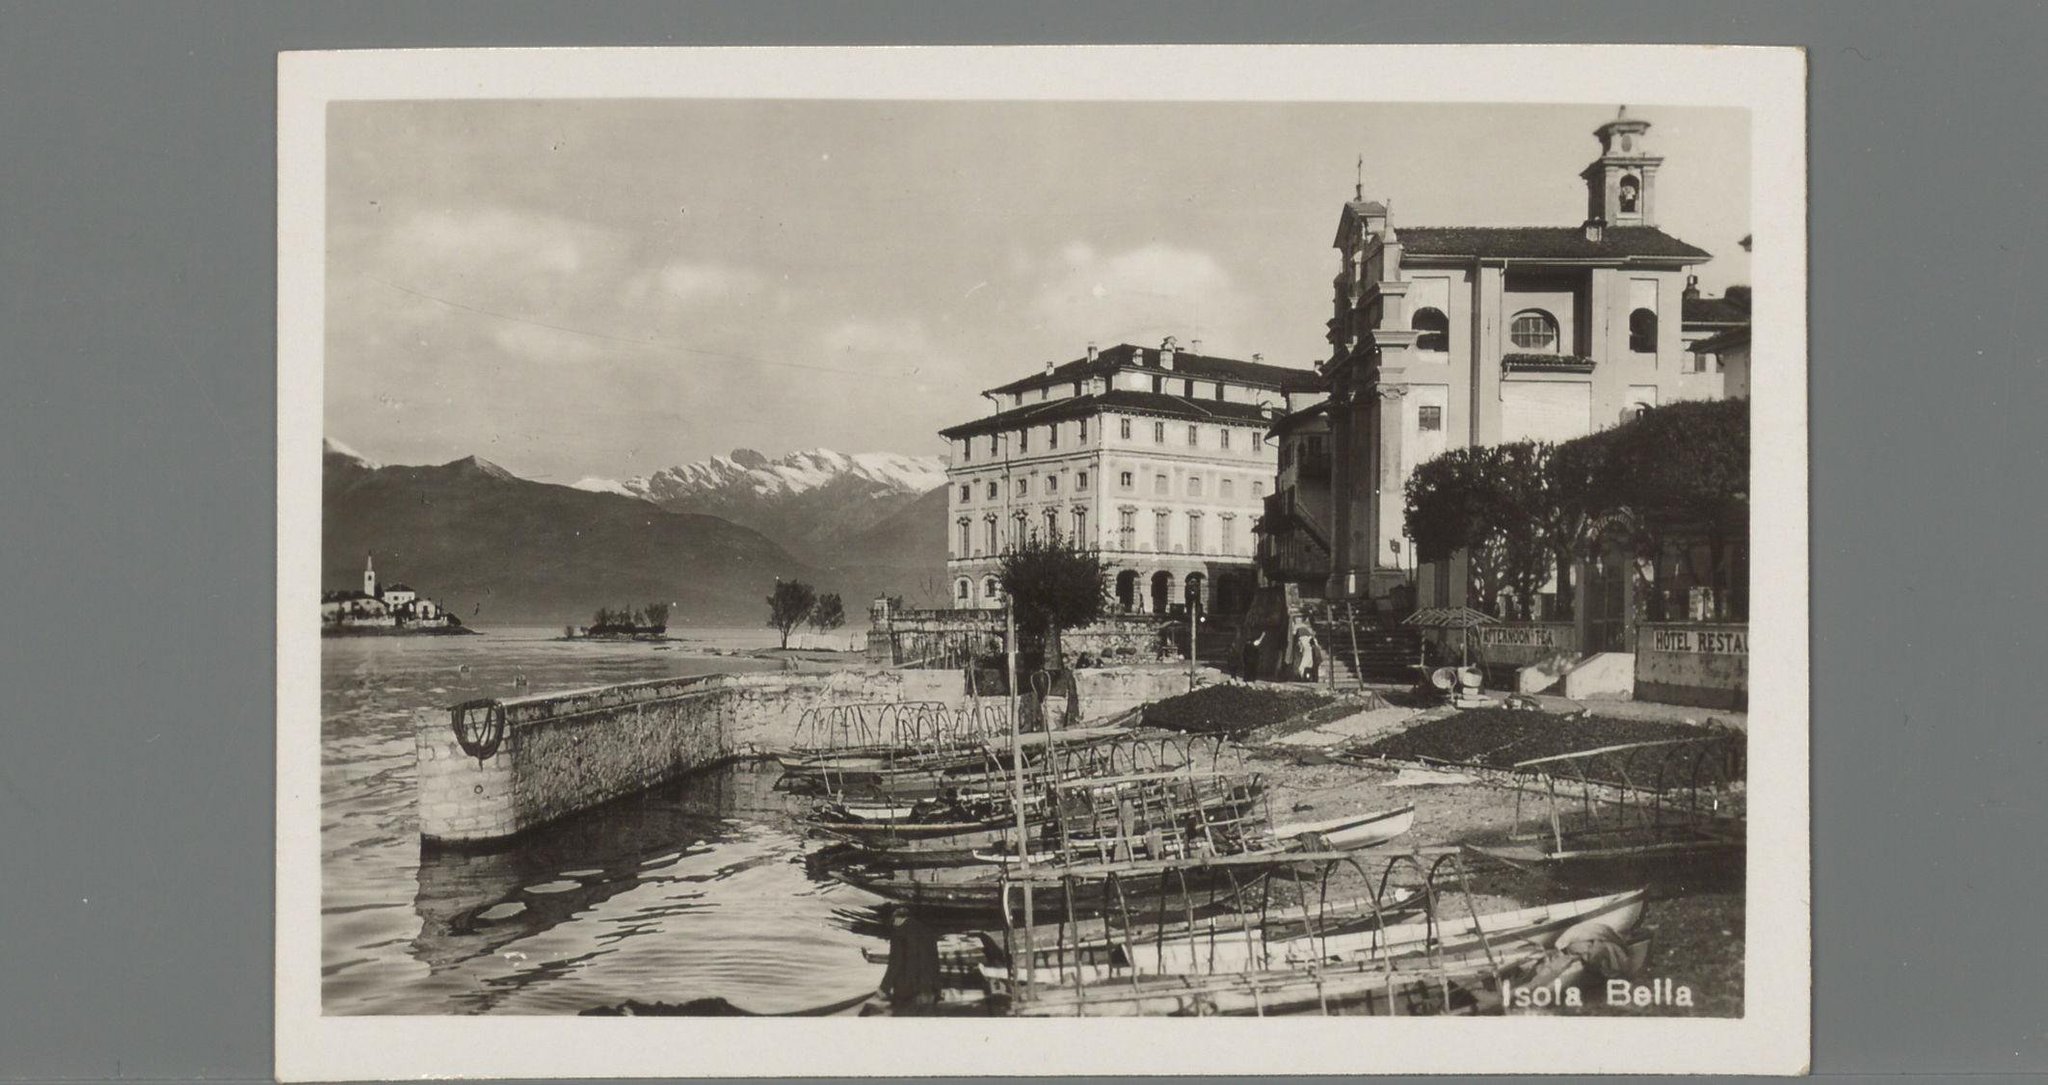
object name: photograph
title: Isola Bella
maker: Anonymous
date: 1904-1935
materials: photographic support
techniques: photography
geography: como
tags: harbour, church (exterior), lake